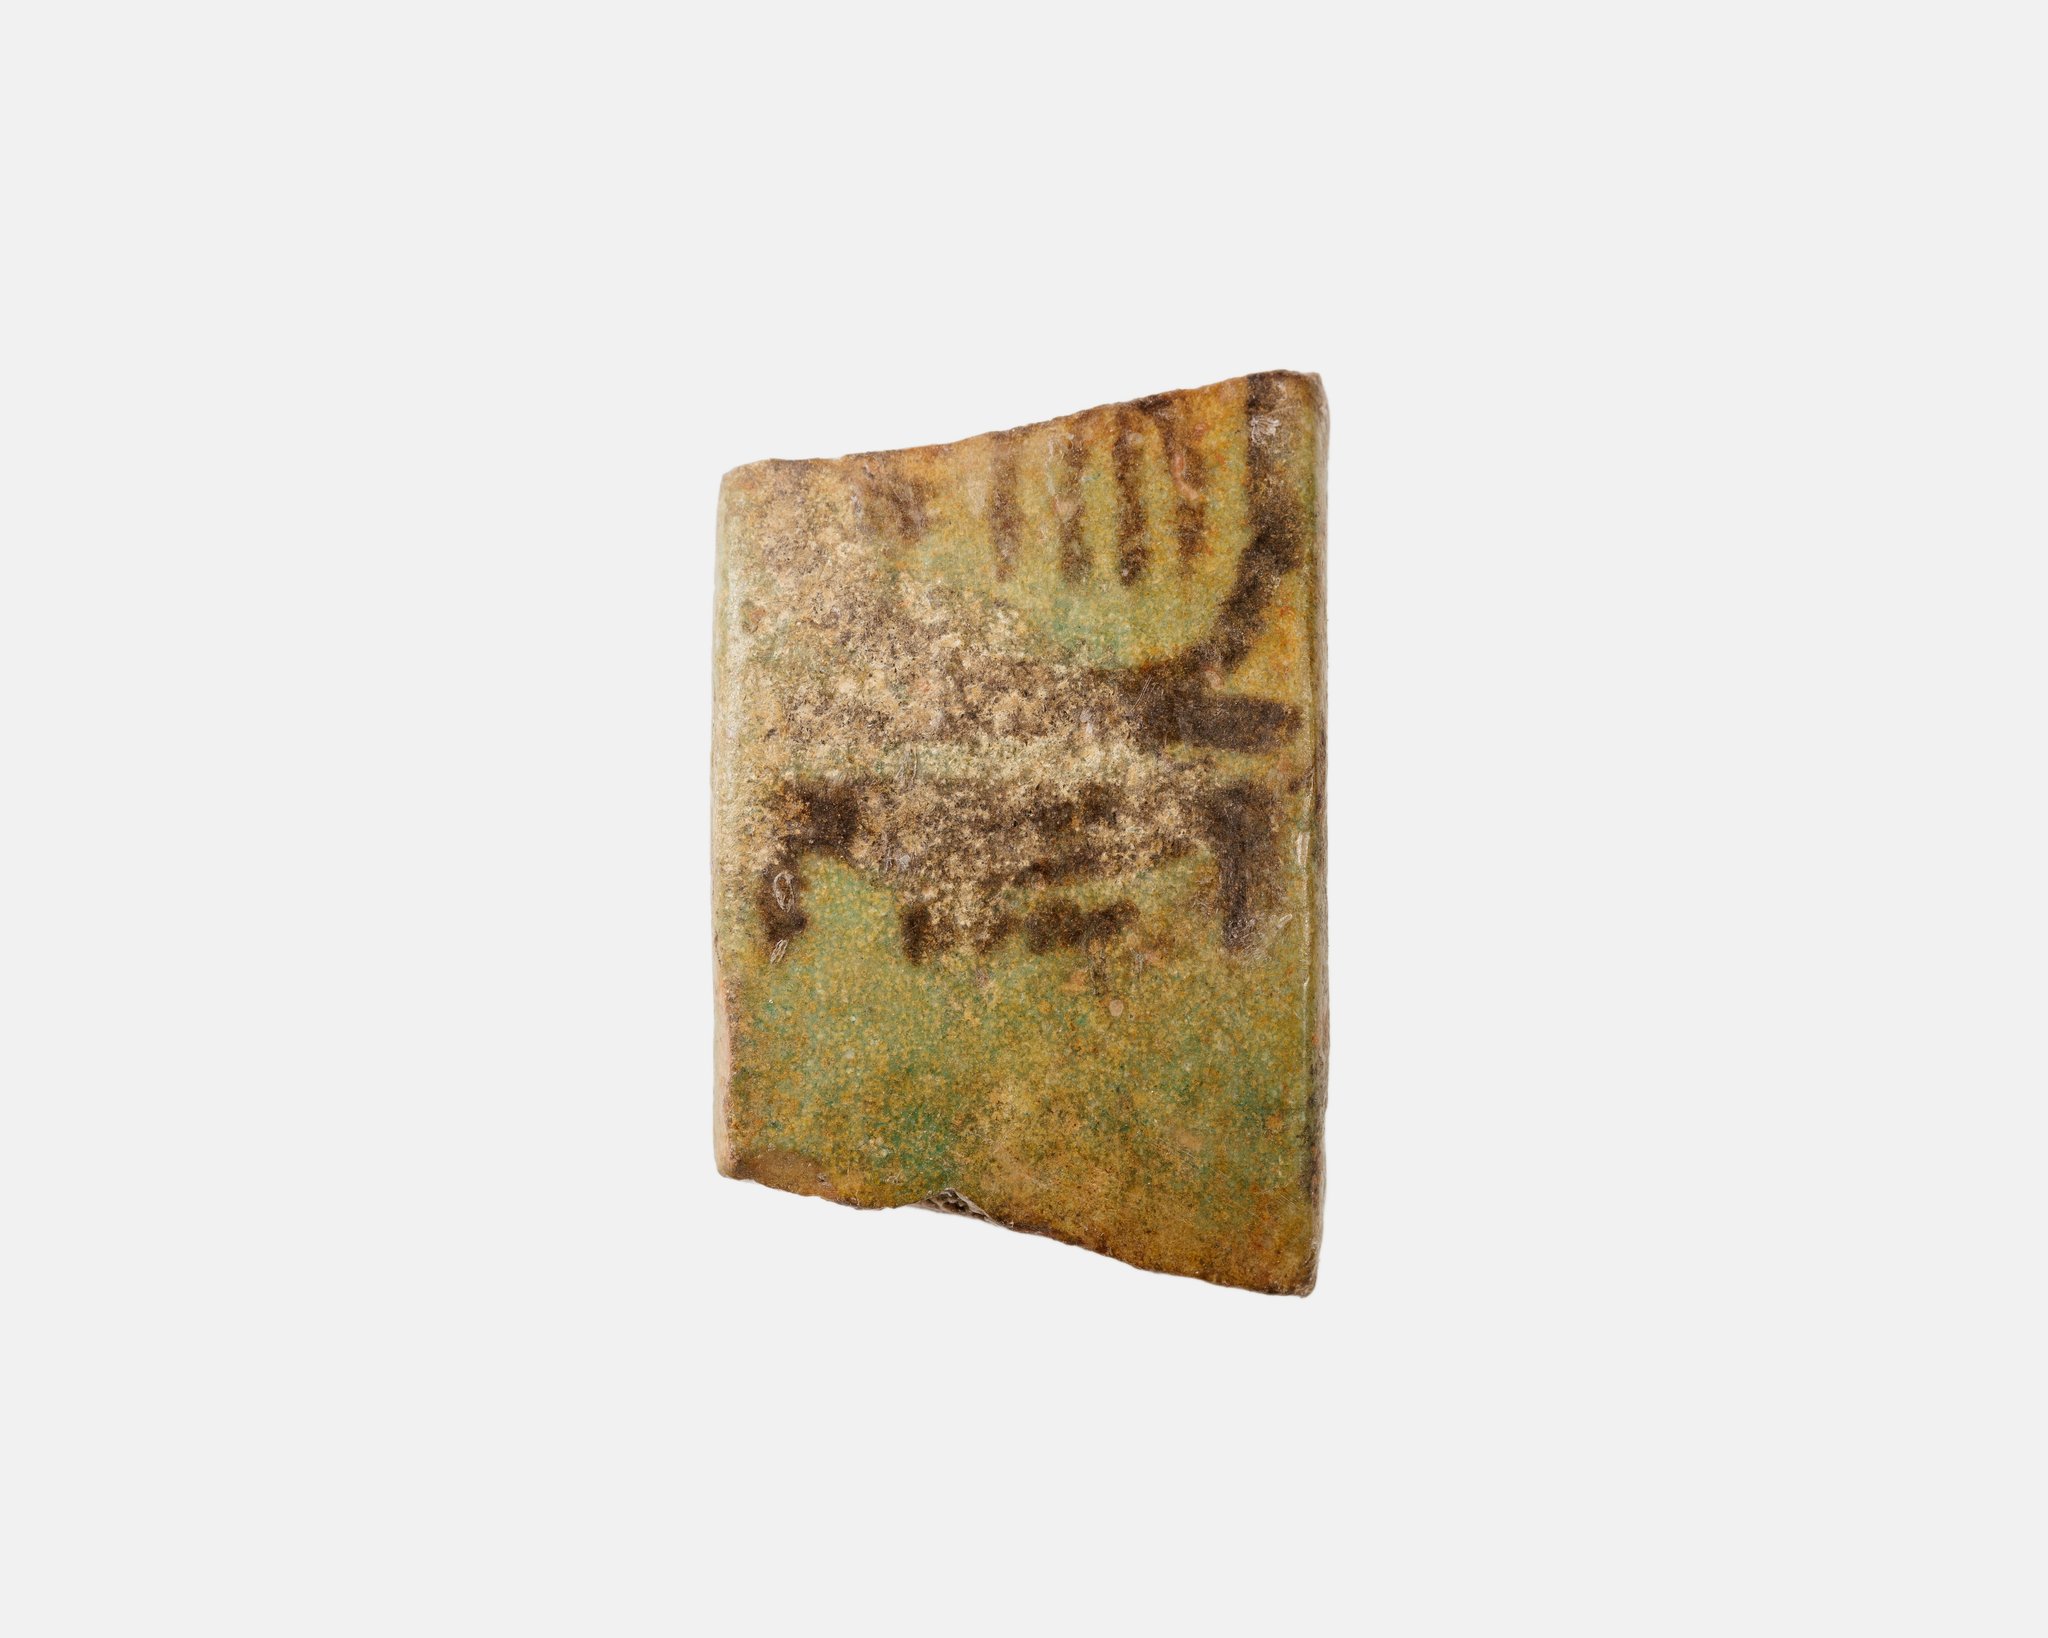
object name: votive bracelet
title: Fragment of a votive bracelet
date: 1295-1070 BCE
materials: faience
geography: egypt